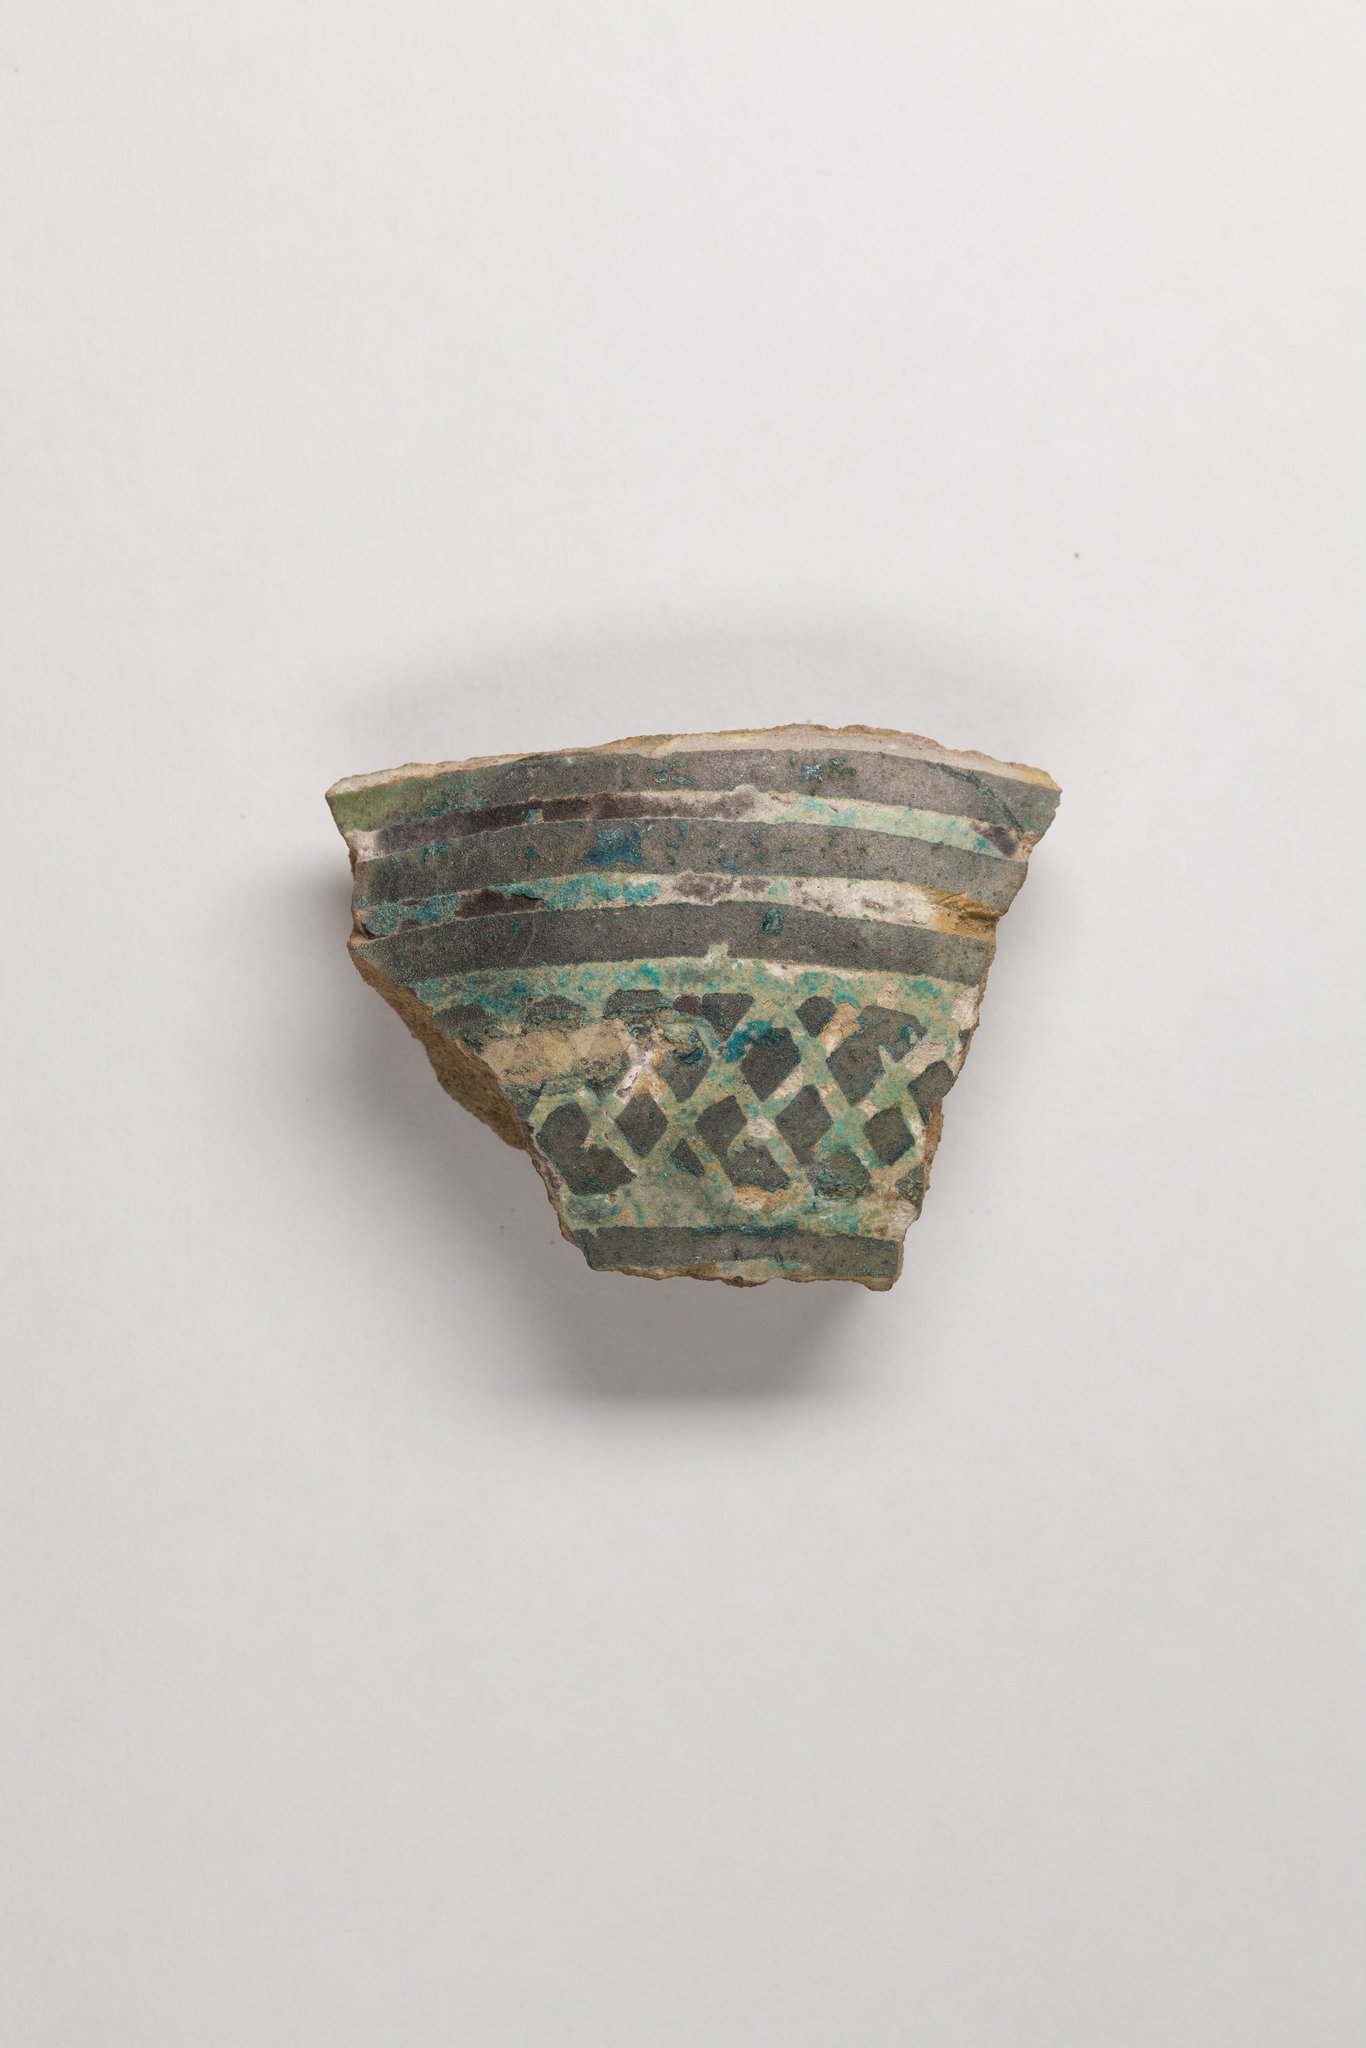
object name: vase fragment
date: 1981-1640 BCE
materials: faience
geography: egypt